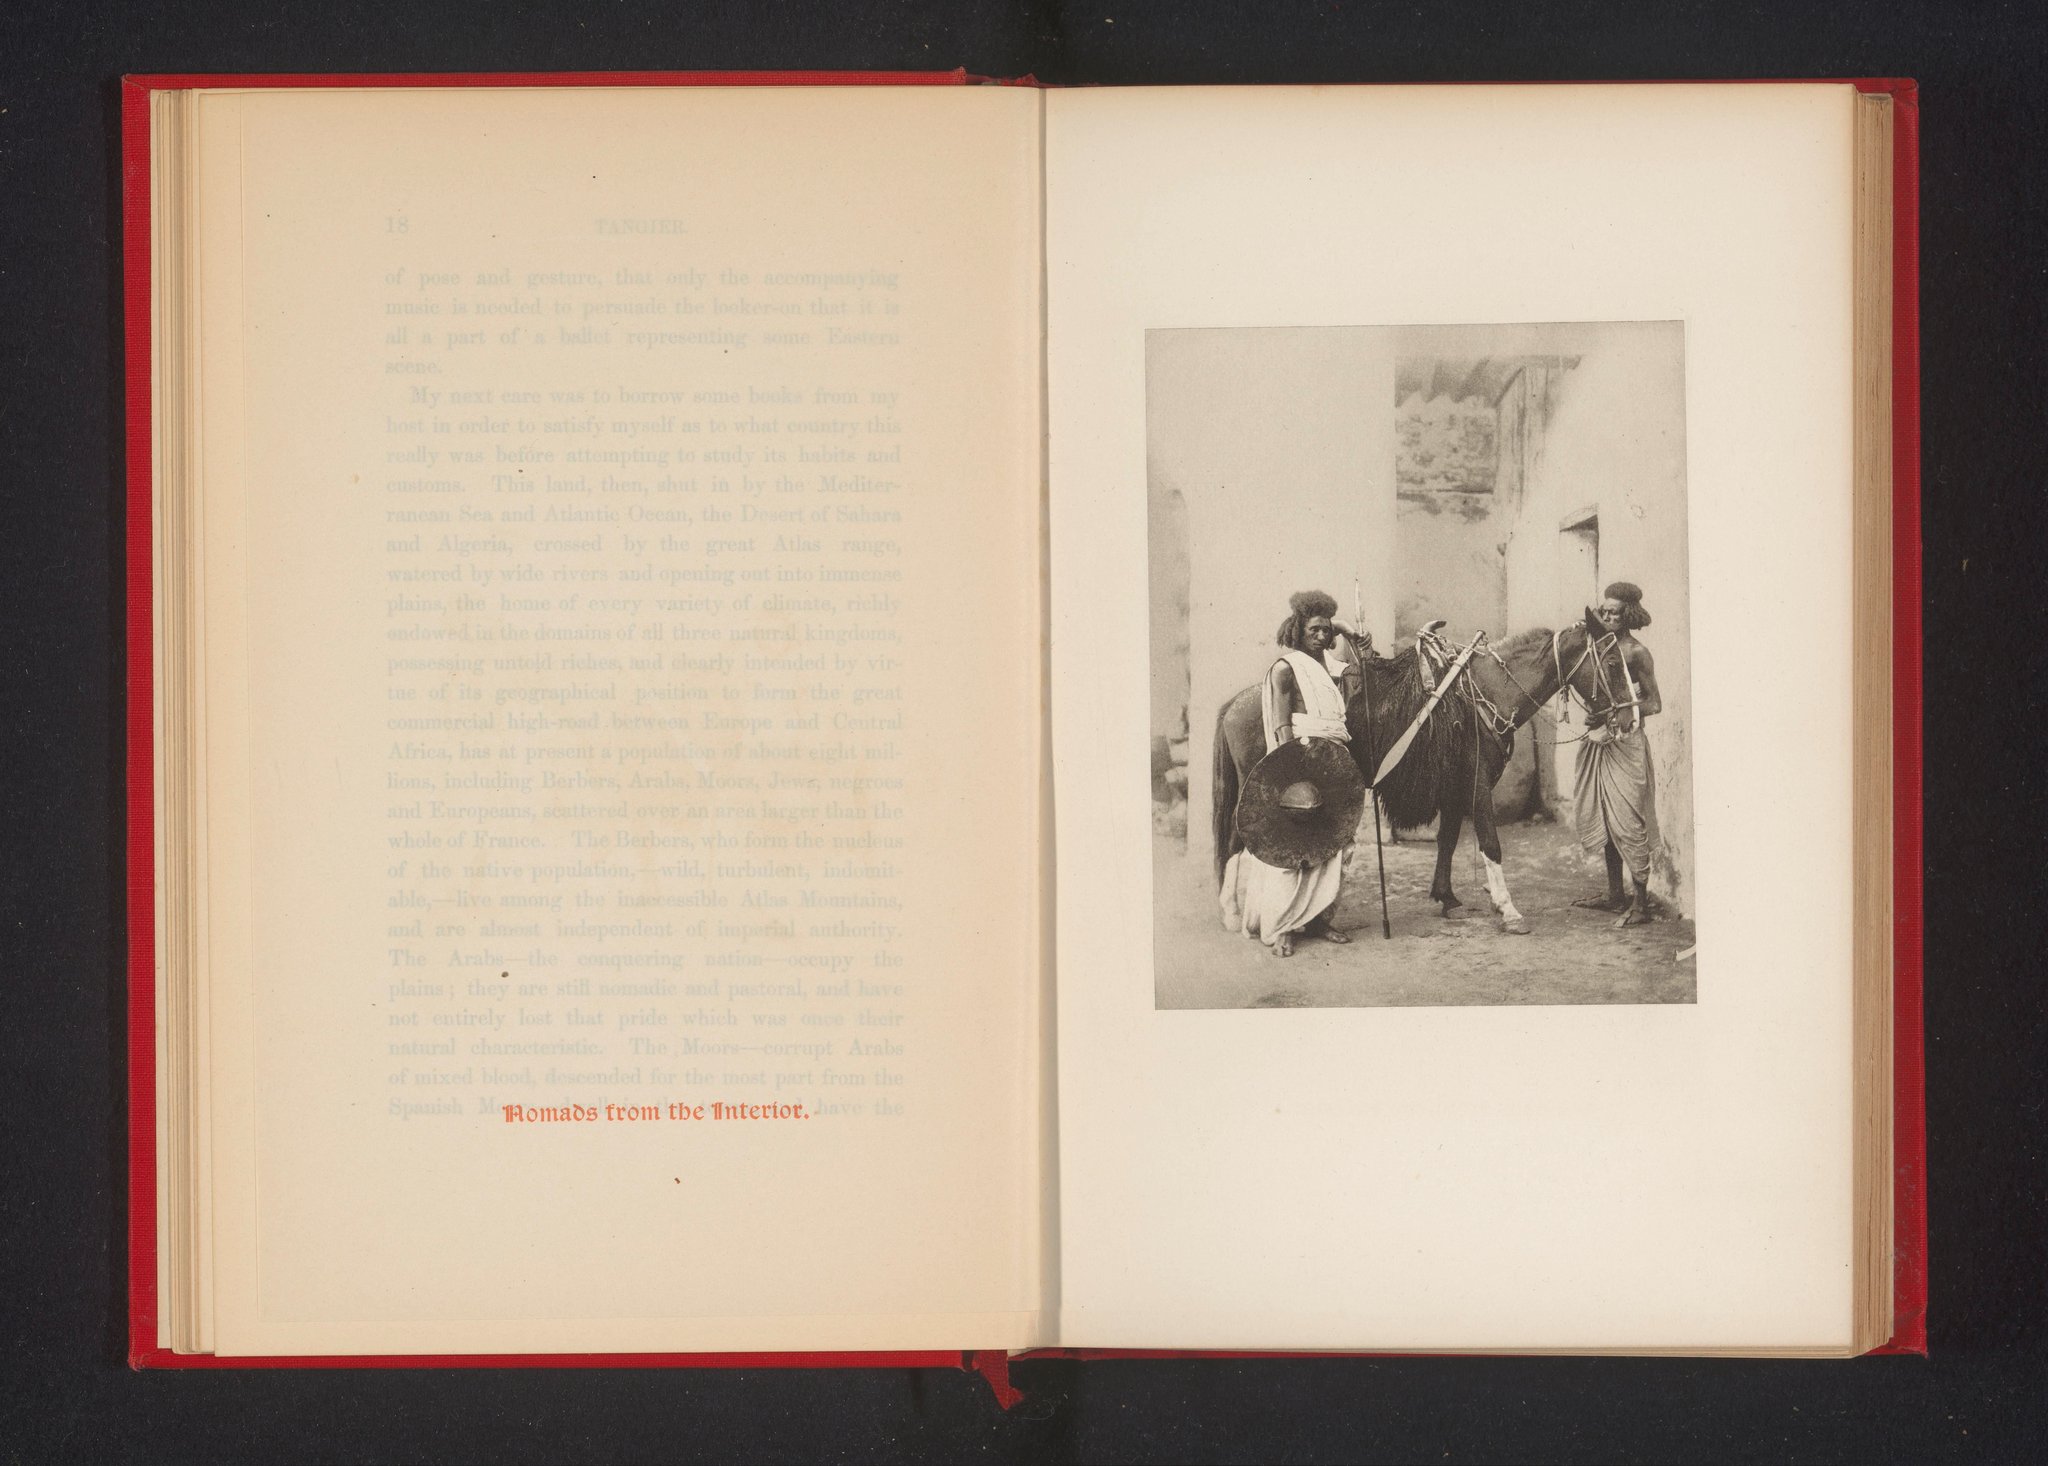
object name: page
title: Twee mannen met een paard op een binnenplaats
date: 1887-1897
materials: paper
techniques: photoaquatint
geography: morocco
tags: adult man, façade of inner court, horse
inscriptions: title: ‘Nomads from the Interior.’